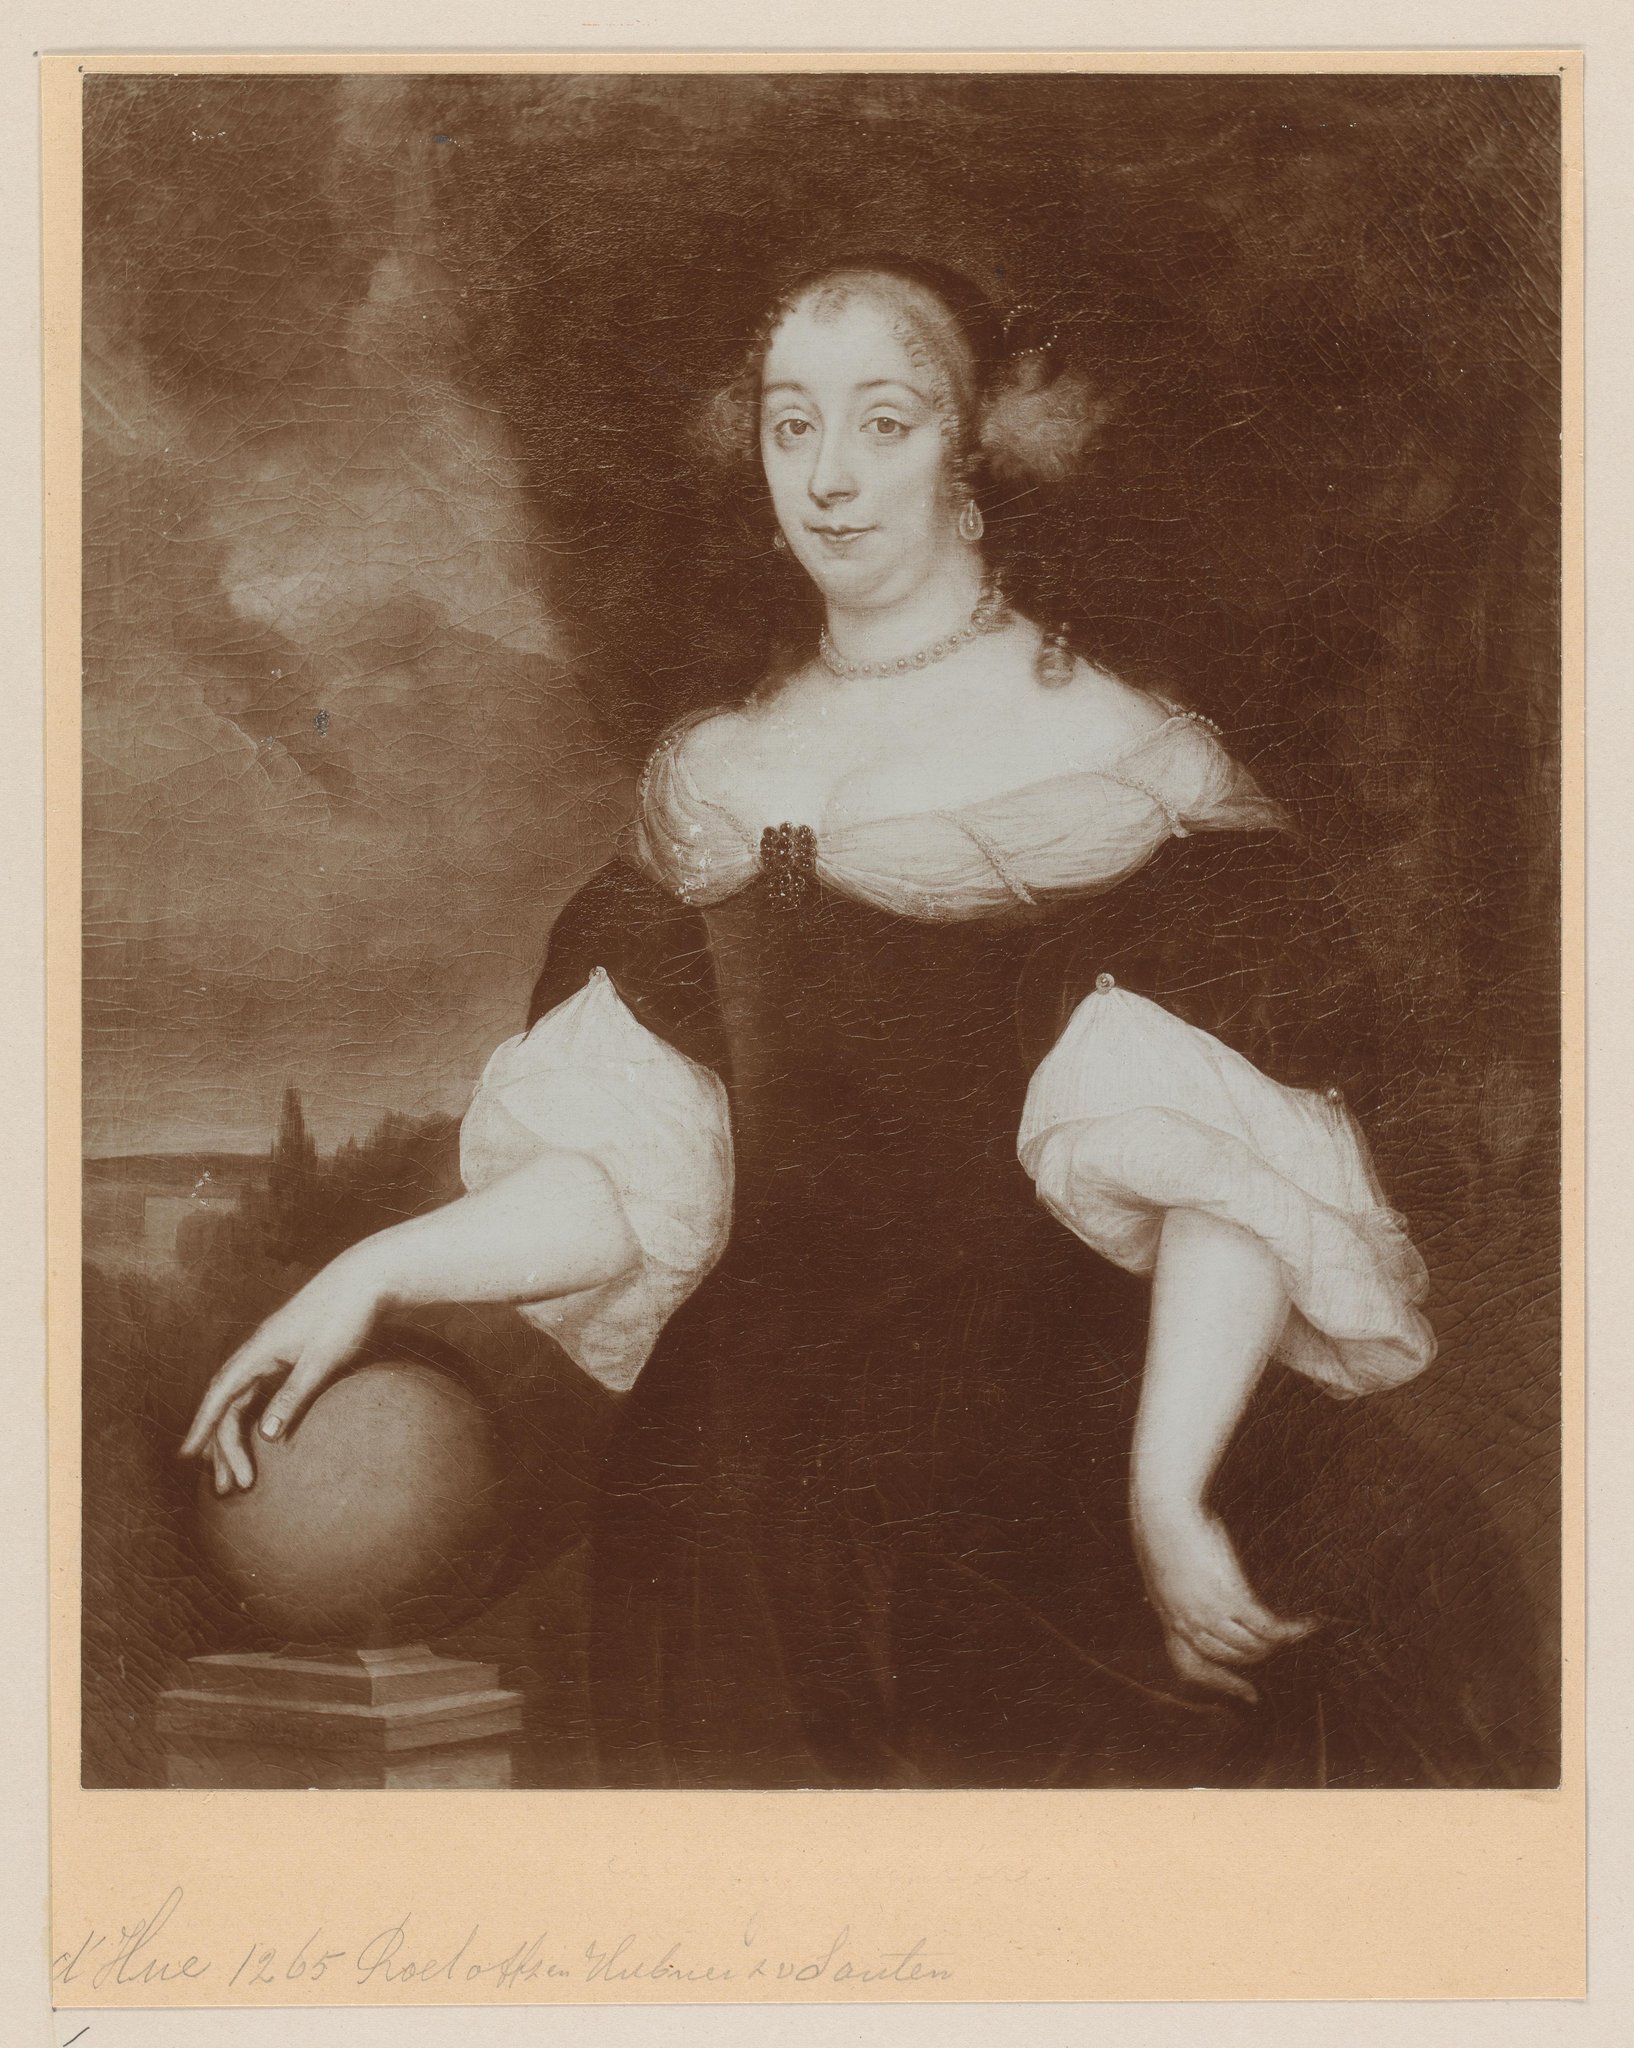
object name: reproduction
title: Fotoreproductie van een geschilderd portret van Margaretha Munter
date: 1880-1910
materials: paper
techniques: collodion silver print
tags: historical persons - bb - woman, picture, painting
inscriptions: collector's mark: Lugt 2228, inscription: ‘d'Hue 1265 Roeloffzen Hubner & v Santen’